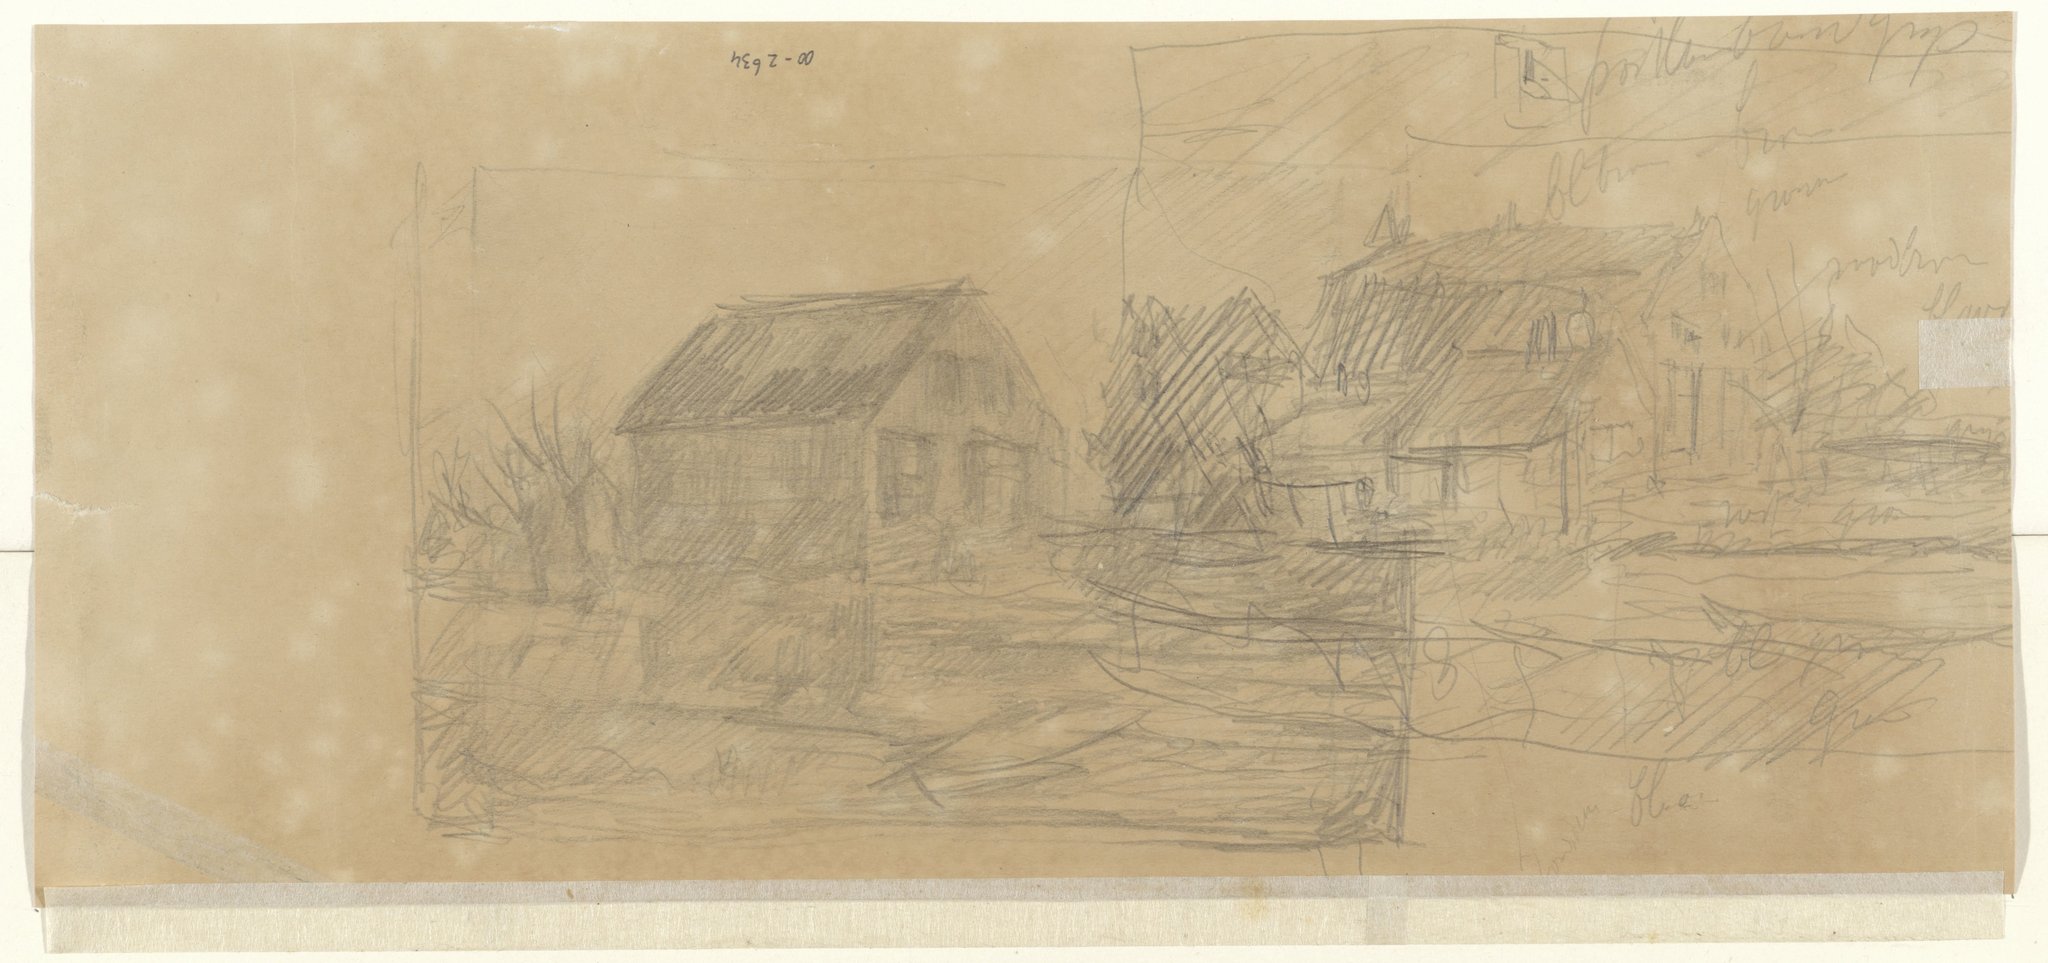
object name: drawing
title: Nederlands landschap met boerderij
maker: thomas cool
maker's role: draughtsman, painter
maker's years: 1851-1904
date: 1861-1904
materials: paper, pencil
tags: farm or solitary house in landscape, farm (building), netherlands